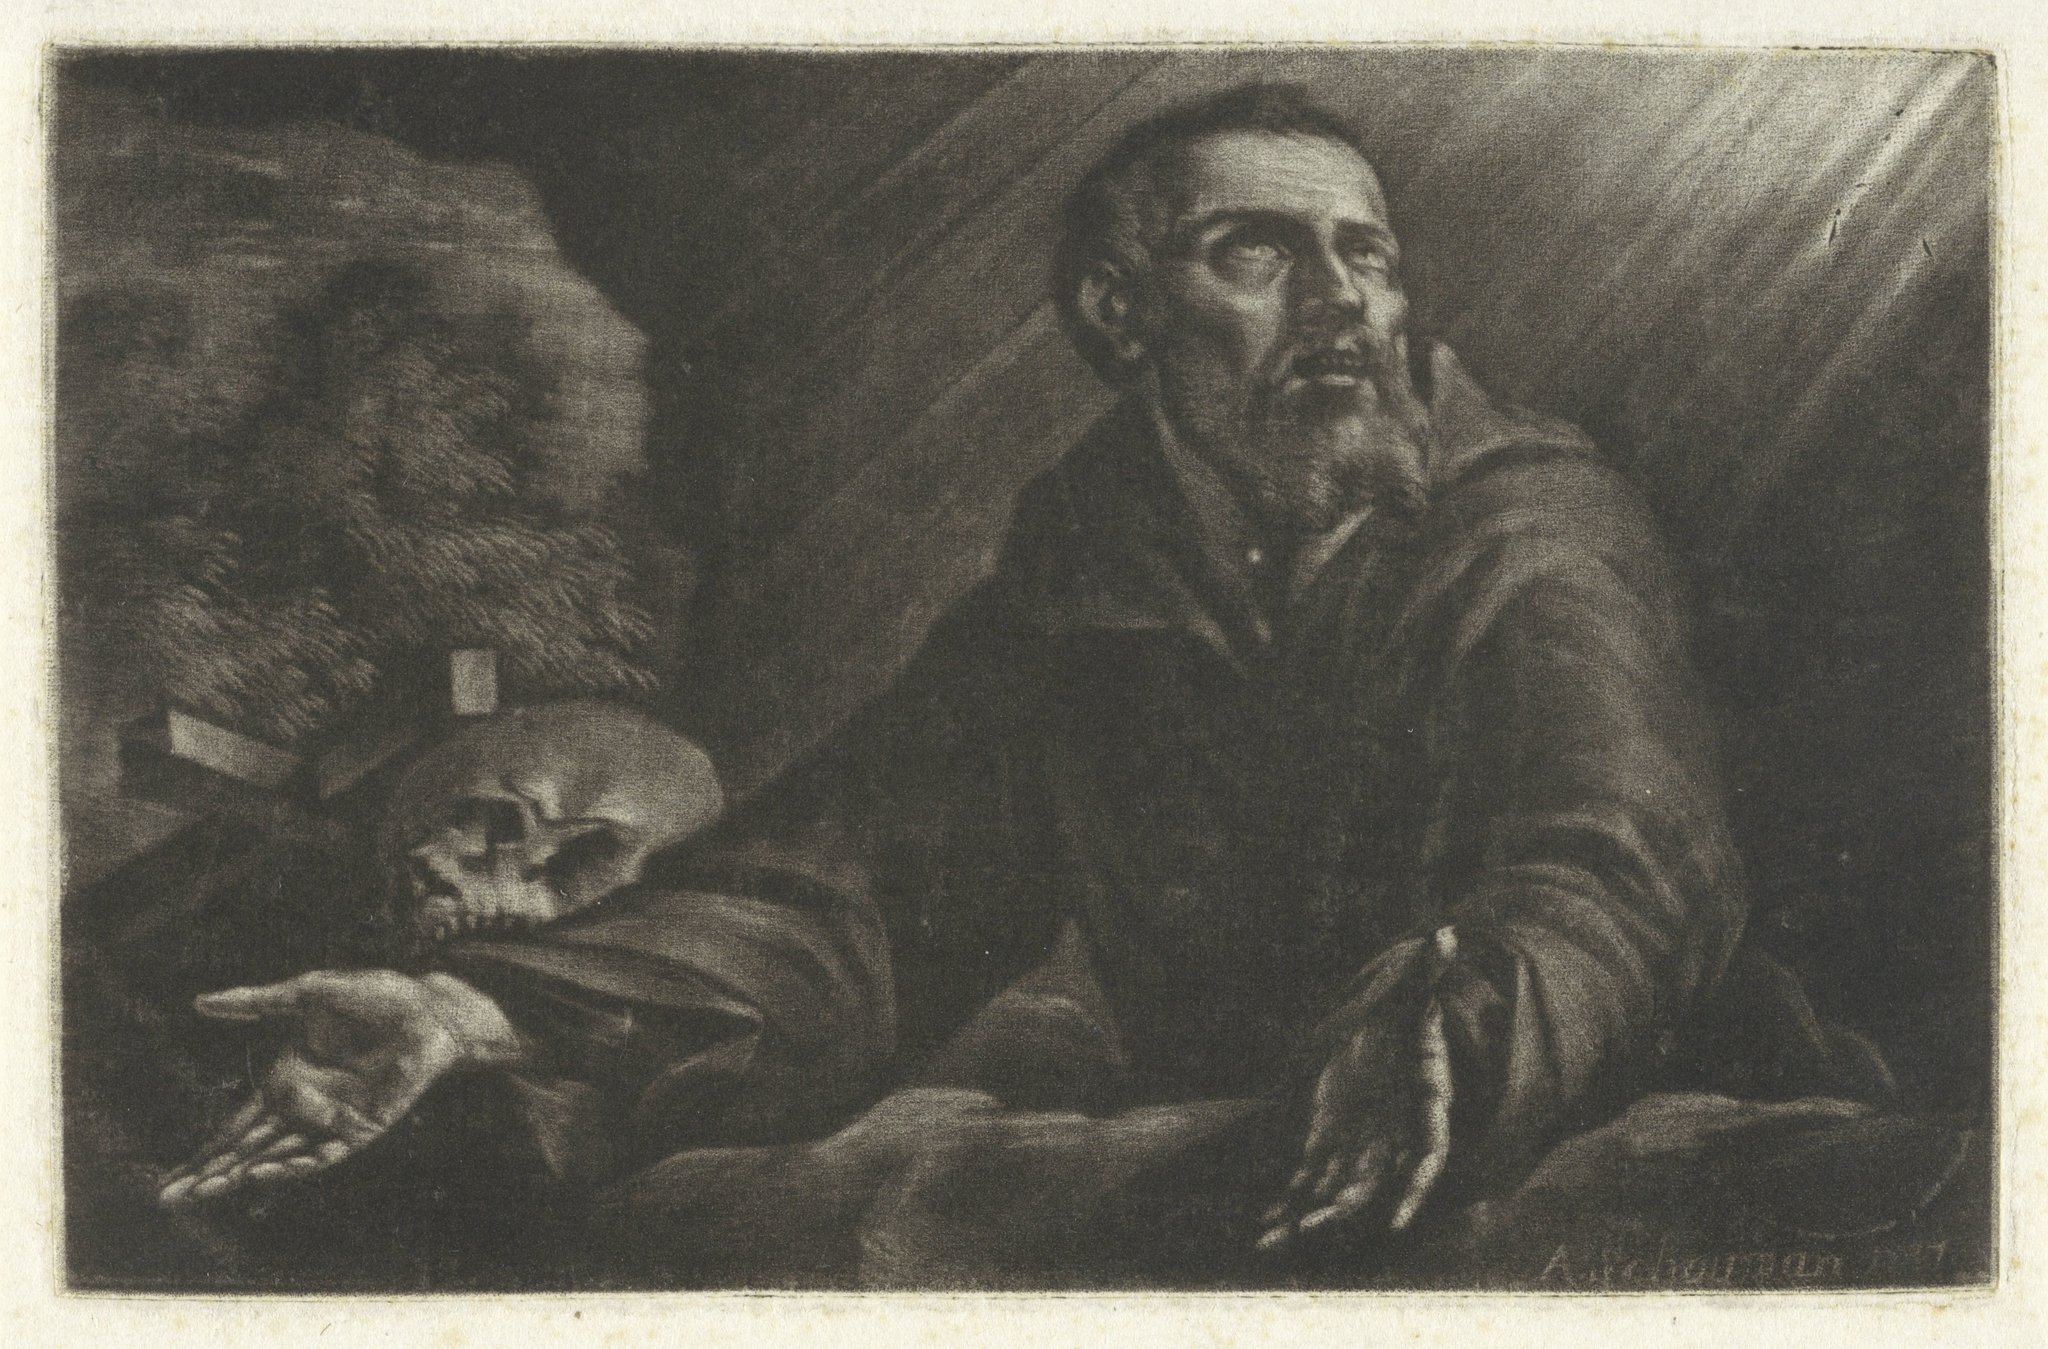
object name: print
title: H. Franciscus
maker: aert schouman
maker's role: draughtsman, painter, print maker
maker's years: 1710-1792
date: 1747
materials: paper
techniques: mezzotint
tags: (human) skull, st. francis of assisi preaching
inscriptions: collector's mark: Lugt 240